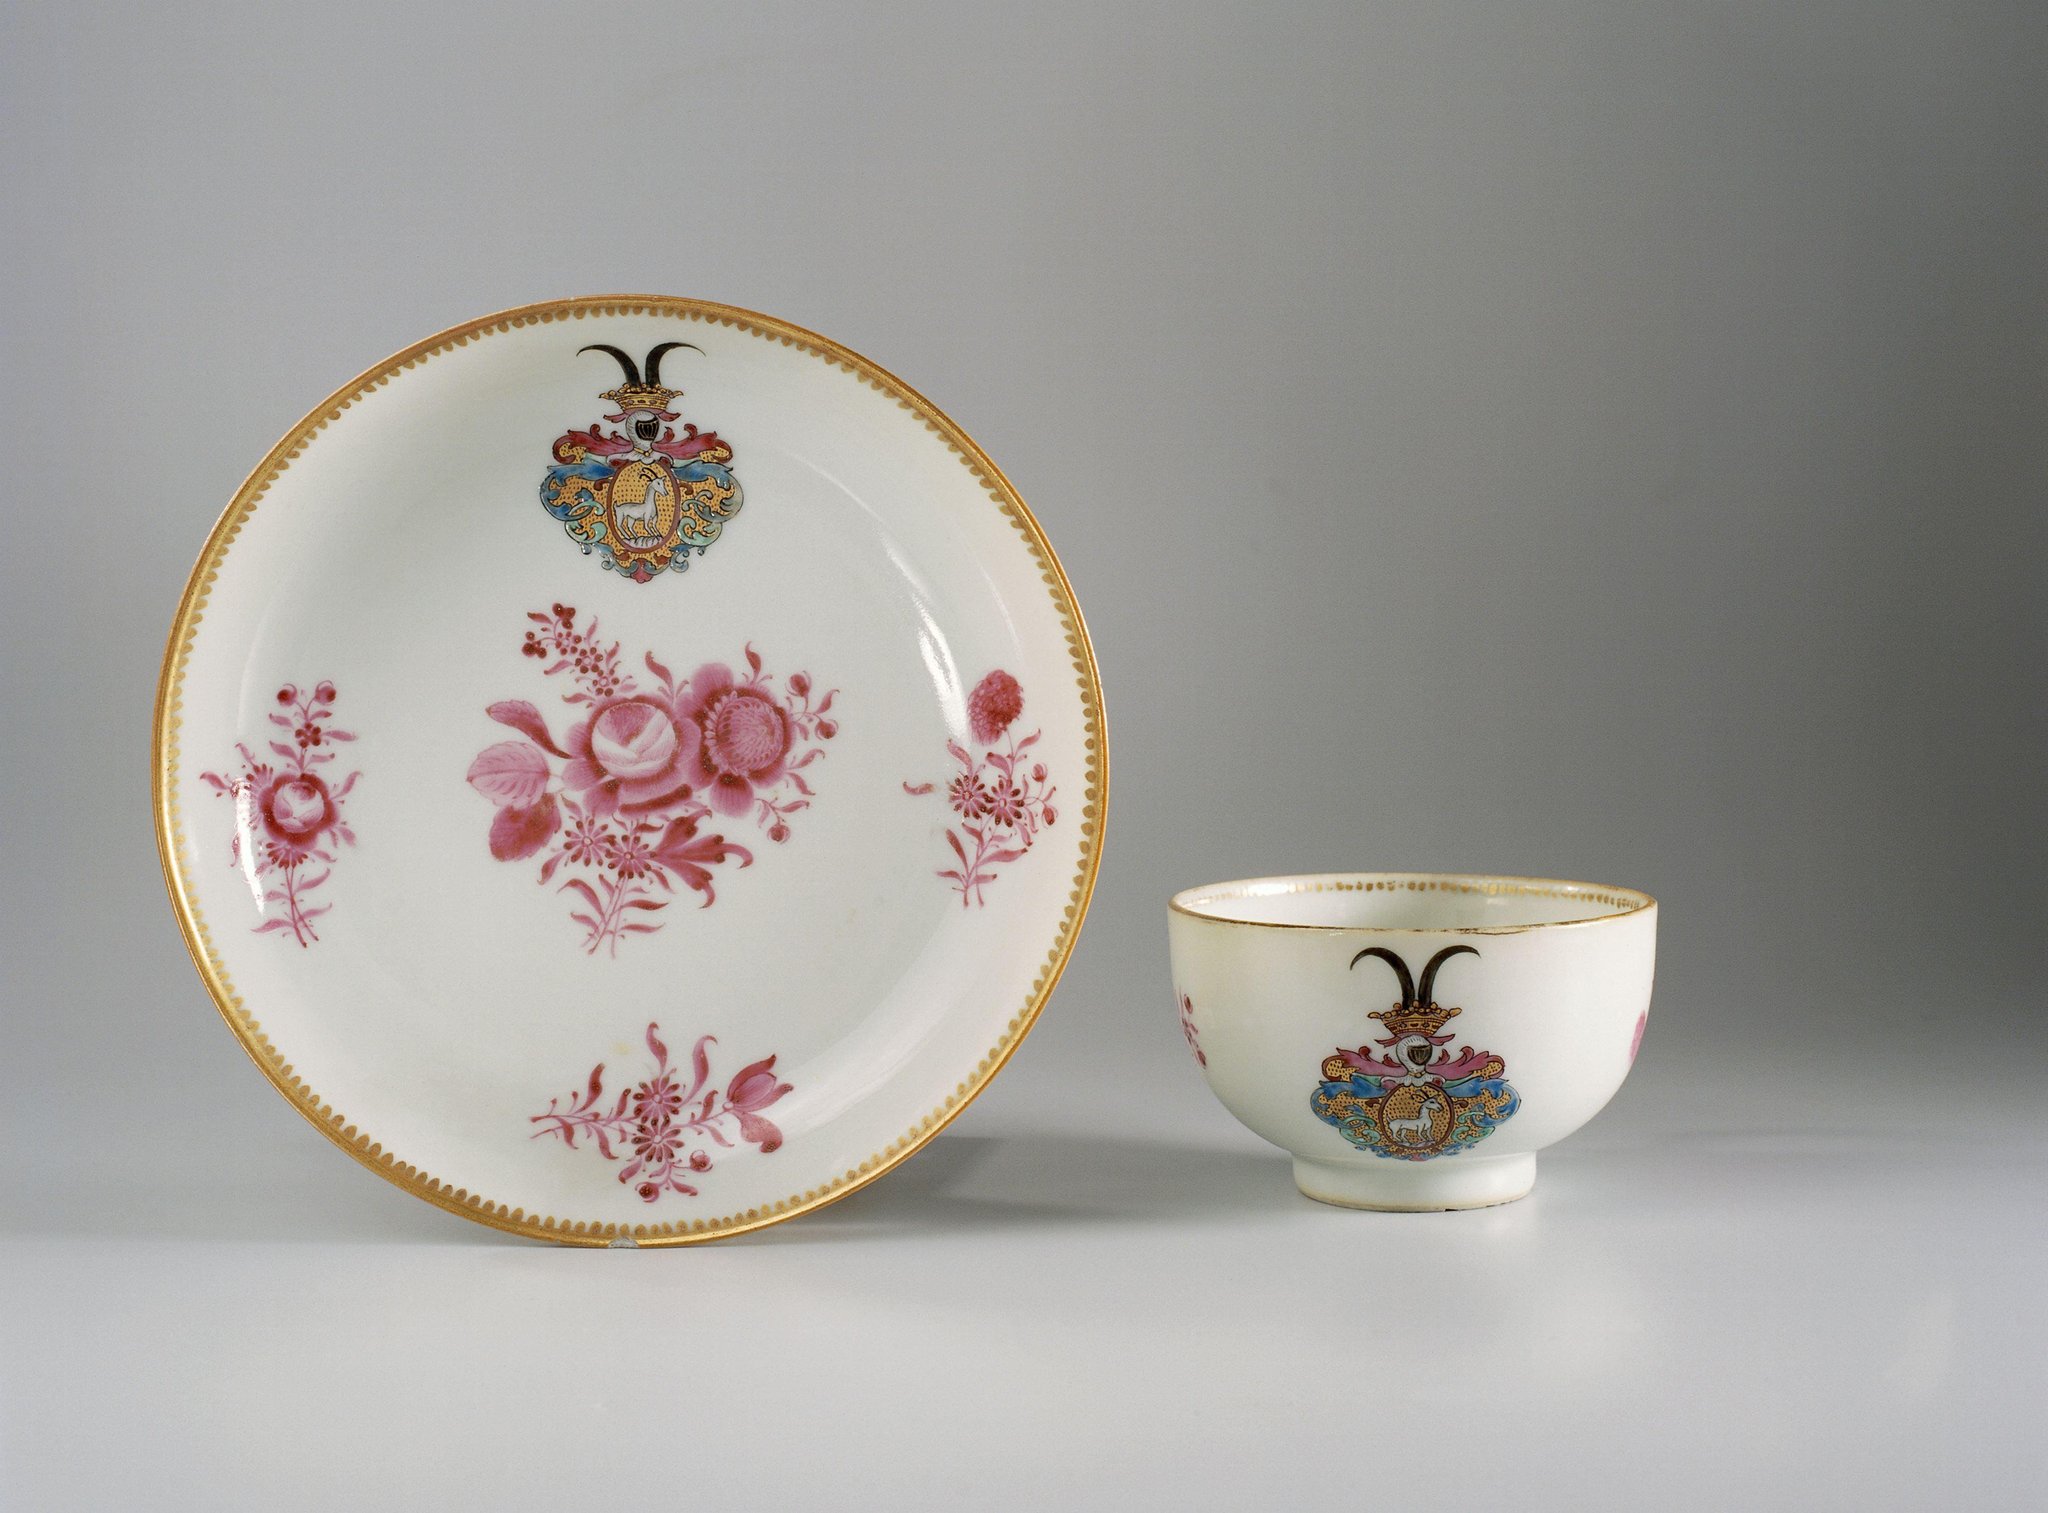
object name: cup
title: Cup with handle with flower bouquets and a coat of arms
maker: Anonymous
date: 1750-1774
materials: glaze, gold, paint, porcelain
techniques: firing, gilding, turning, vitrification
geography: china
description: Oorkop van porselein, beschilderd op het glazuur in blauw, rood, roze, groen, zwart en goud. Op de wand een boeket met bloemen en drie bloemtakken (en camaïeu) en een ongeïdentificeerd familiewapen. Op het wapen een ram op een rots tegen een goud gespikkelde achtergrond. Het helmteken is een kroon met twee horens. Het dekkleed bestaat uit bladranken. Op de binnenrand een decoratieve band. Wapenporselein met emailkleuren.